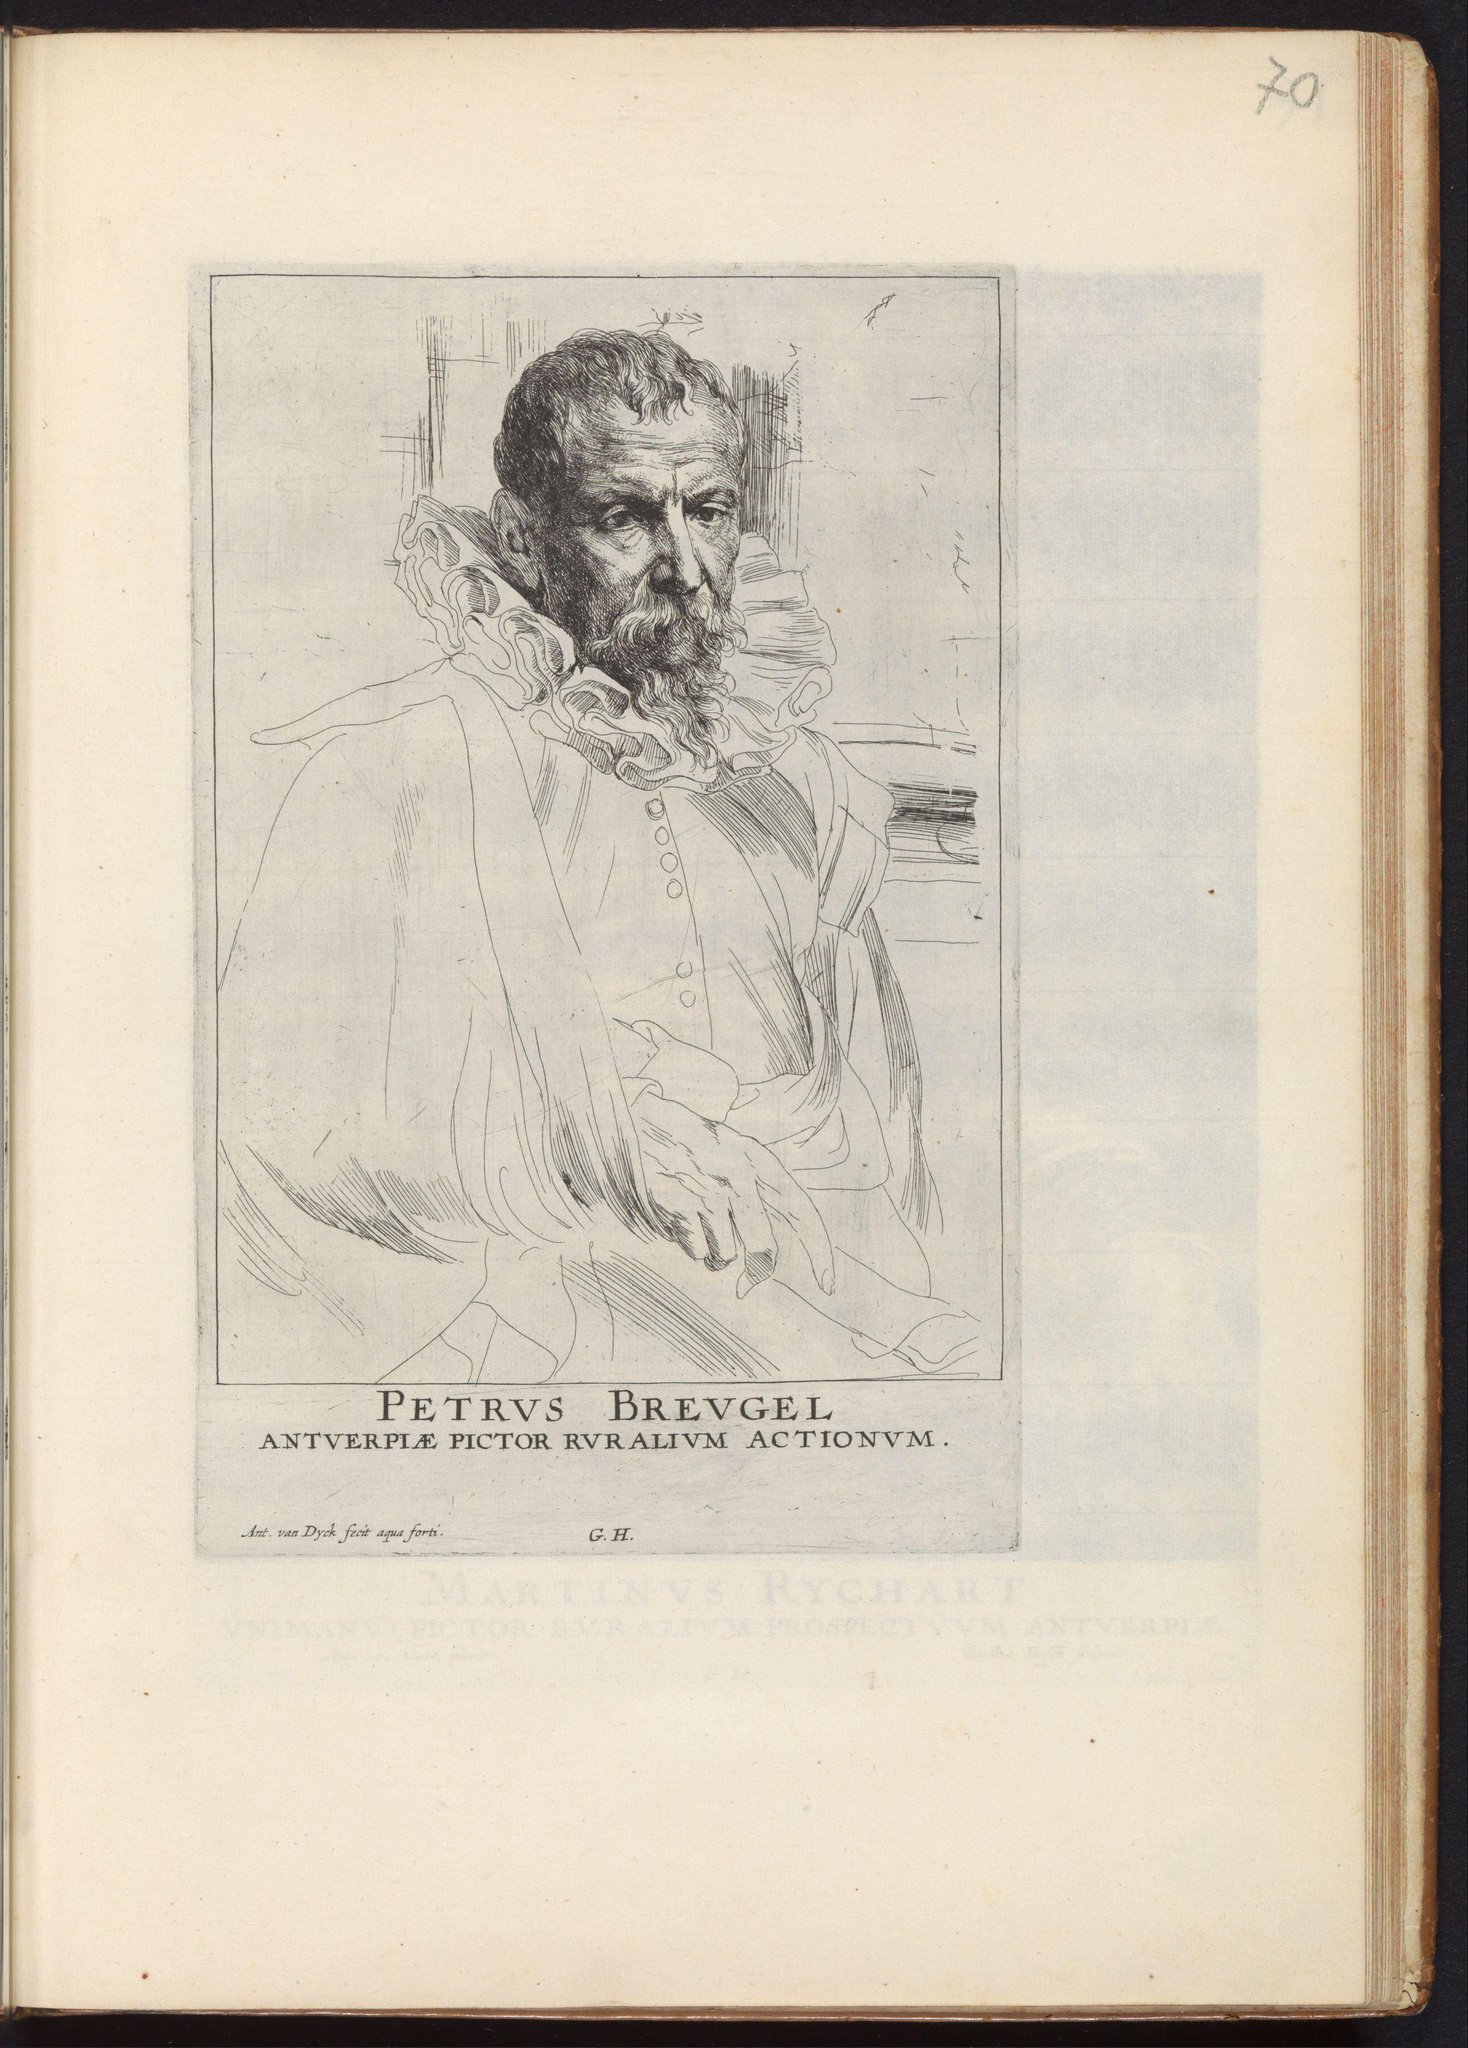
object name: print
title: Icones Principum Vivorum Doctorum Pictorum Chalcographorum Statuariorum nec non Amatorum Pictoriae Artis Numero Centum ab Antonio van Dyck Pictore ad Vivum Expressae Eiusq: Sumptibus aeri incisae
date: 1630-1632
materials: paper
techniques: engraving, etching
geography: antwerp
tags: brussels, antwerp, draughtsman, pieter brueghel (ii), portrait, self-portrait of painter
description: Deze prent maakt deel uit van een album.